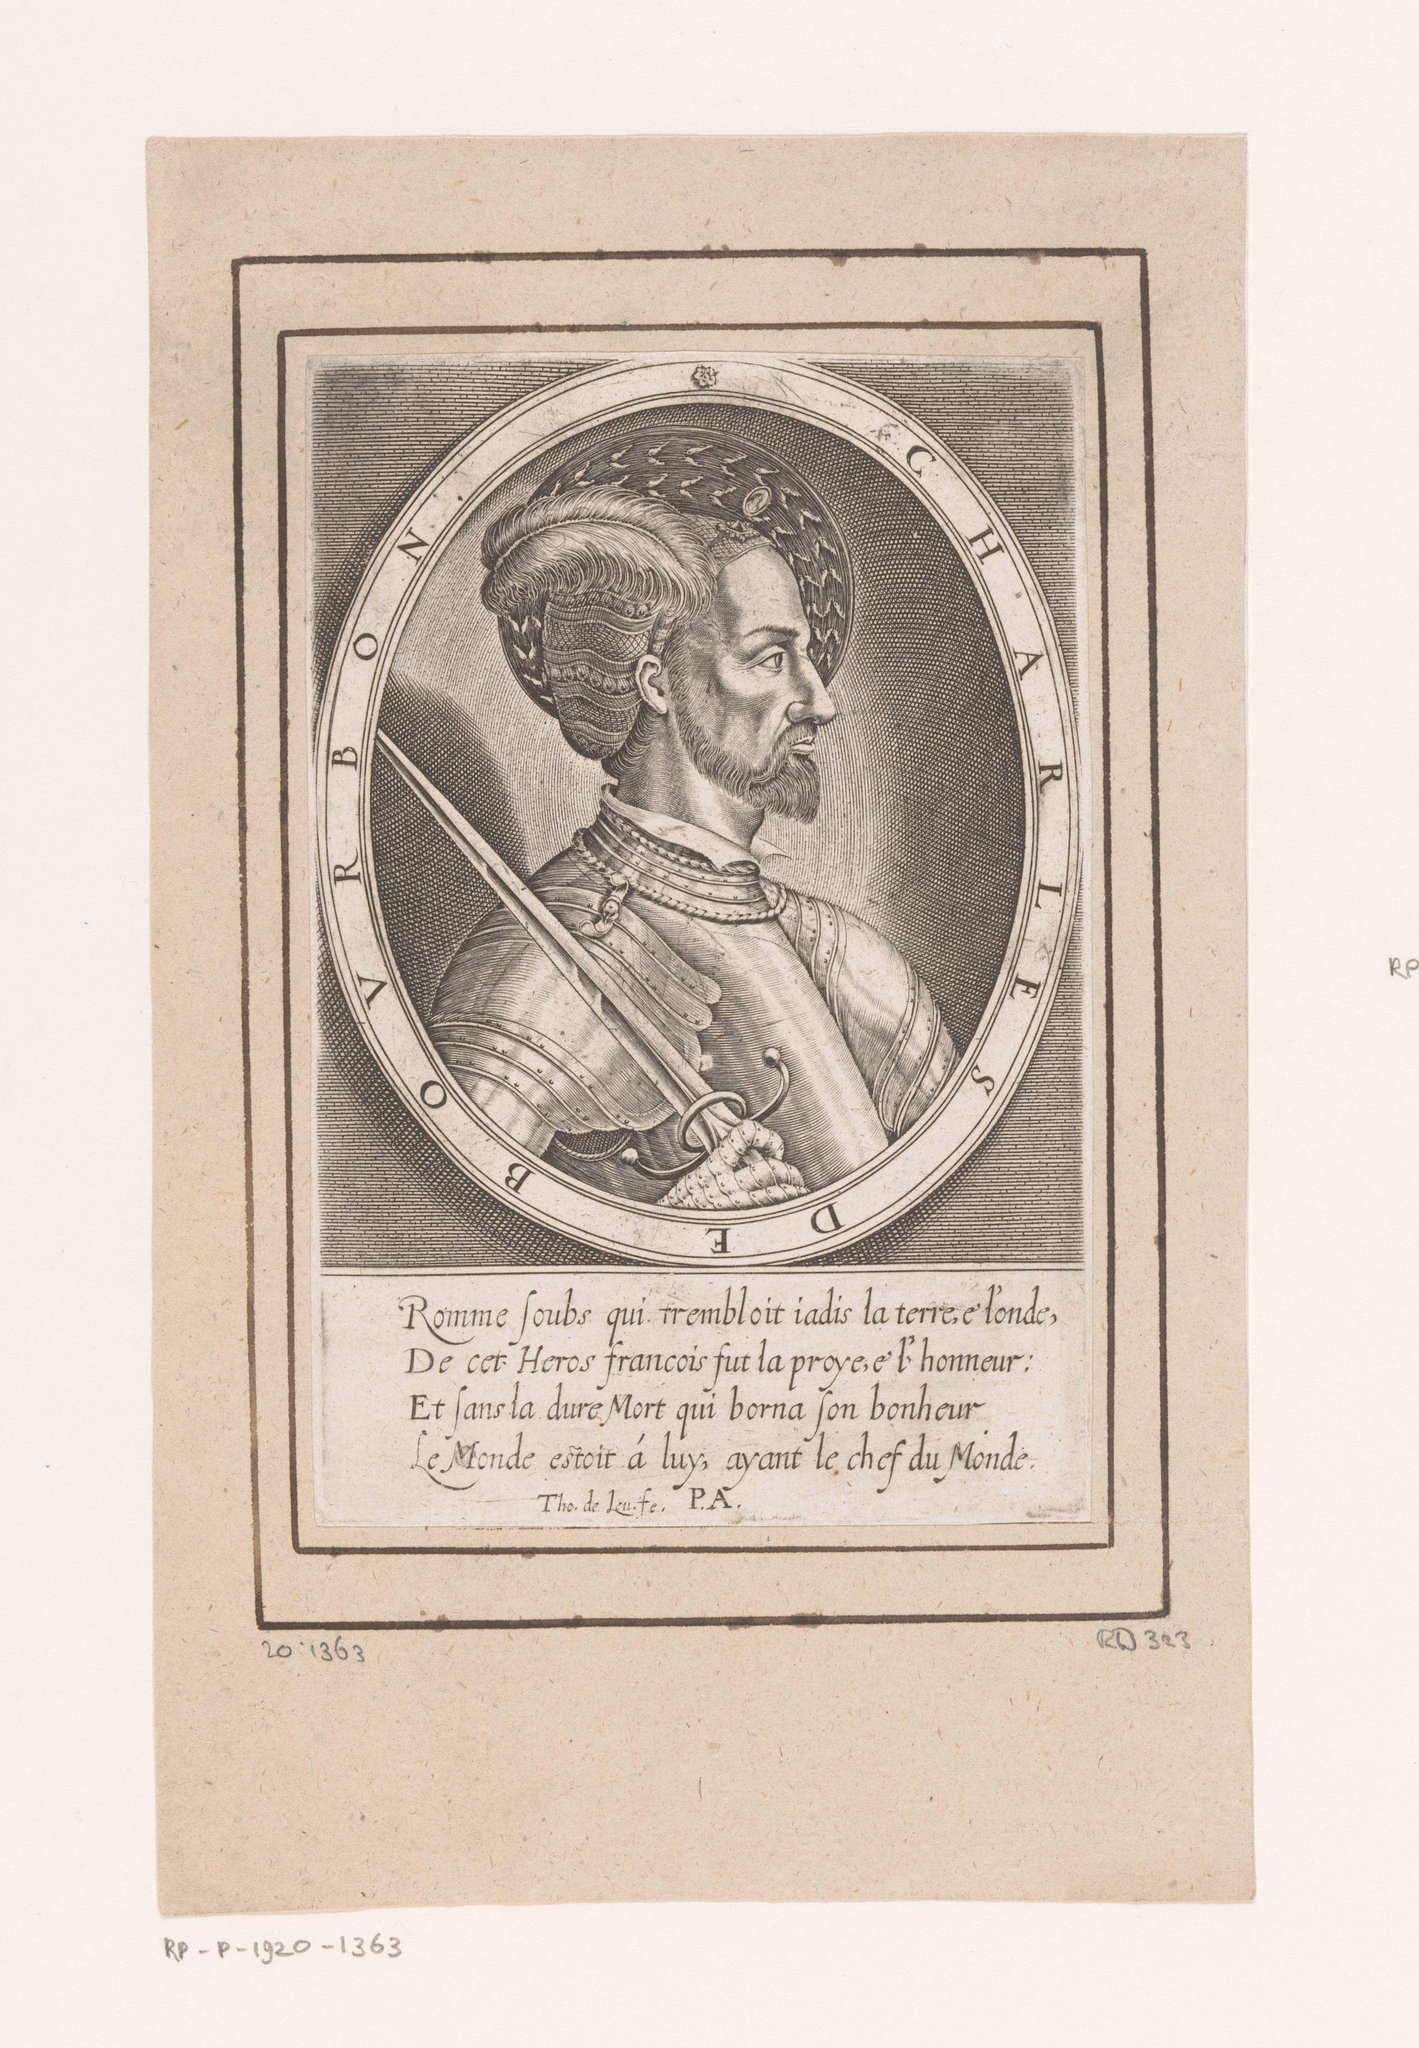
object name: print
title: Portret van Karel III, hertog van Bourbon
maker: thomas de leu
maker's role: print maker, publisher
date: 1576-1614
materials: ink, paper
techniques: engraving, pen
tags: cuirass, historical persons, hacking and thrusting weapons: sword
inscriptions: collector's mark: Lugt 2228